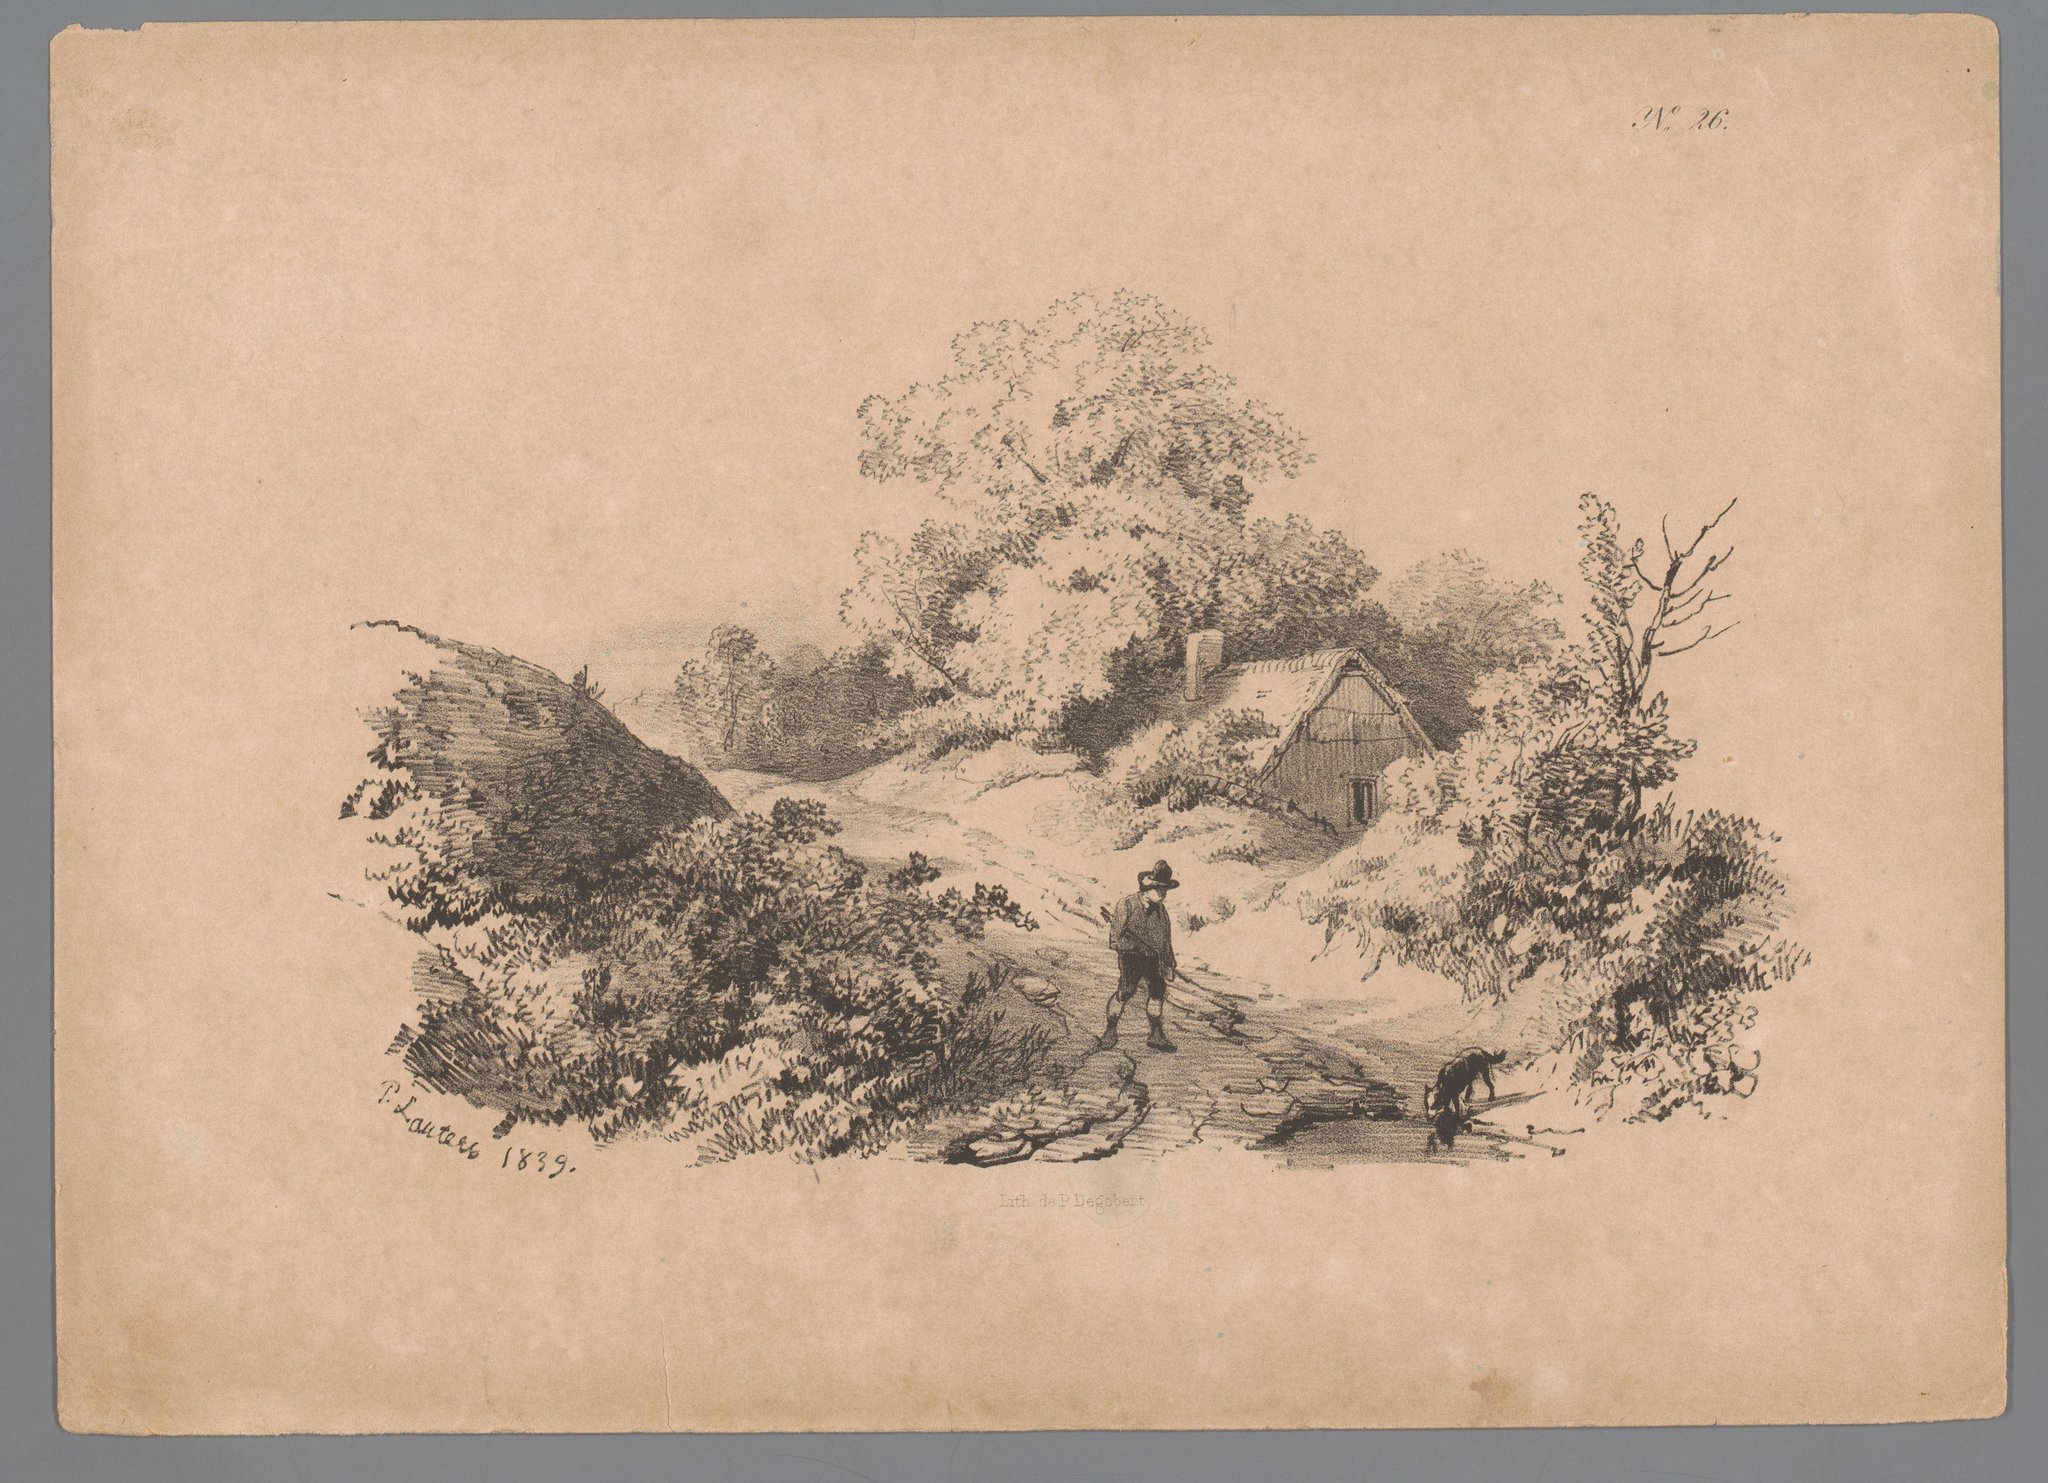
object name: print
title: Landschap met man en hond op een landweg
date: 1839-1840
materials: paper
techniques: lithograph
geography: brussels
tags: road, path, landscapes (+ landscape with figures, staffage), dog